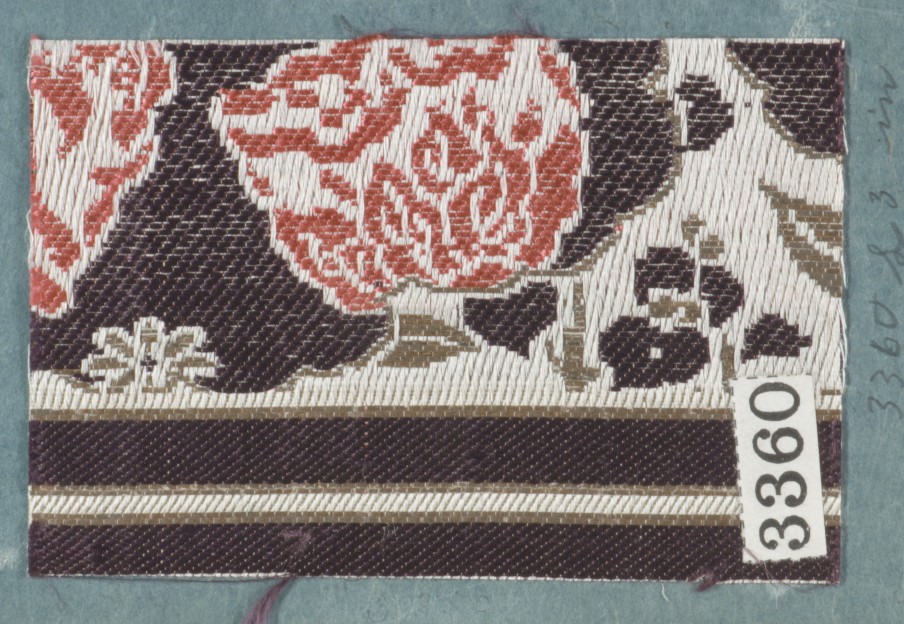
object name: textile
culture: japanese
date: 1801-1900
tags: flowers